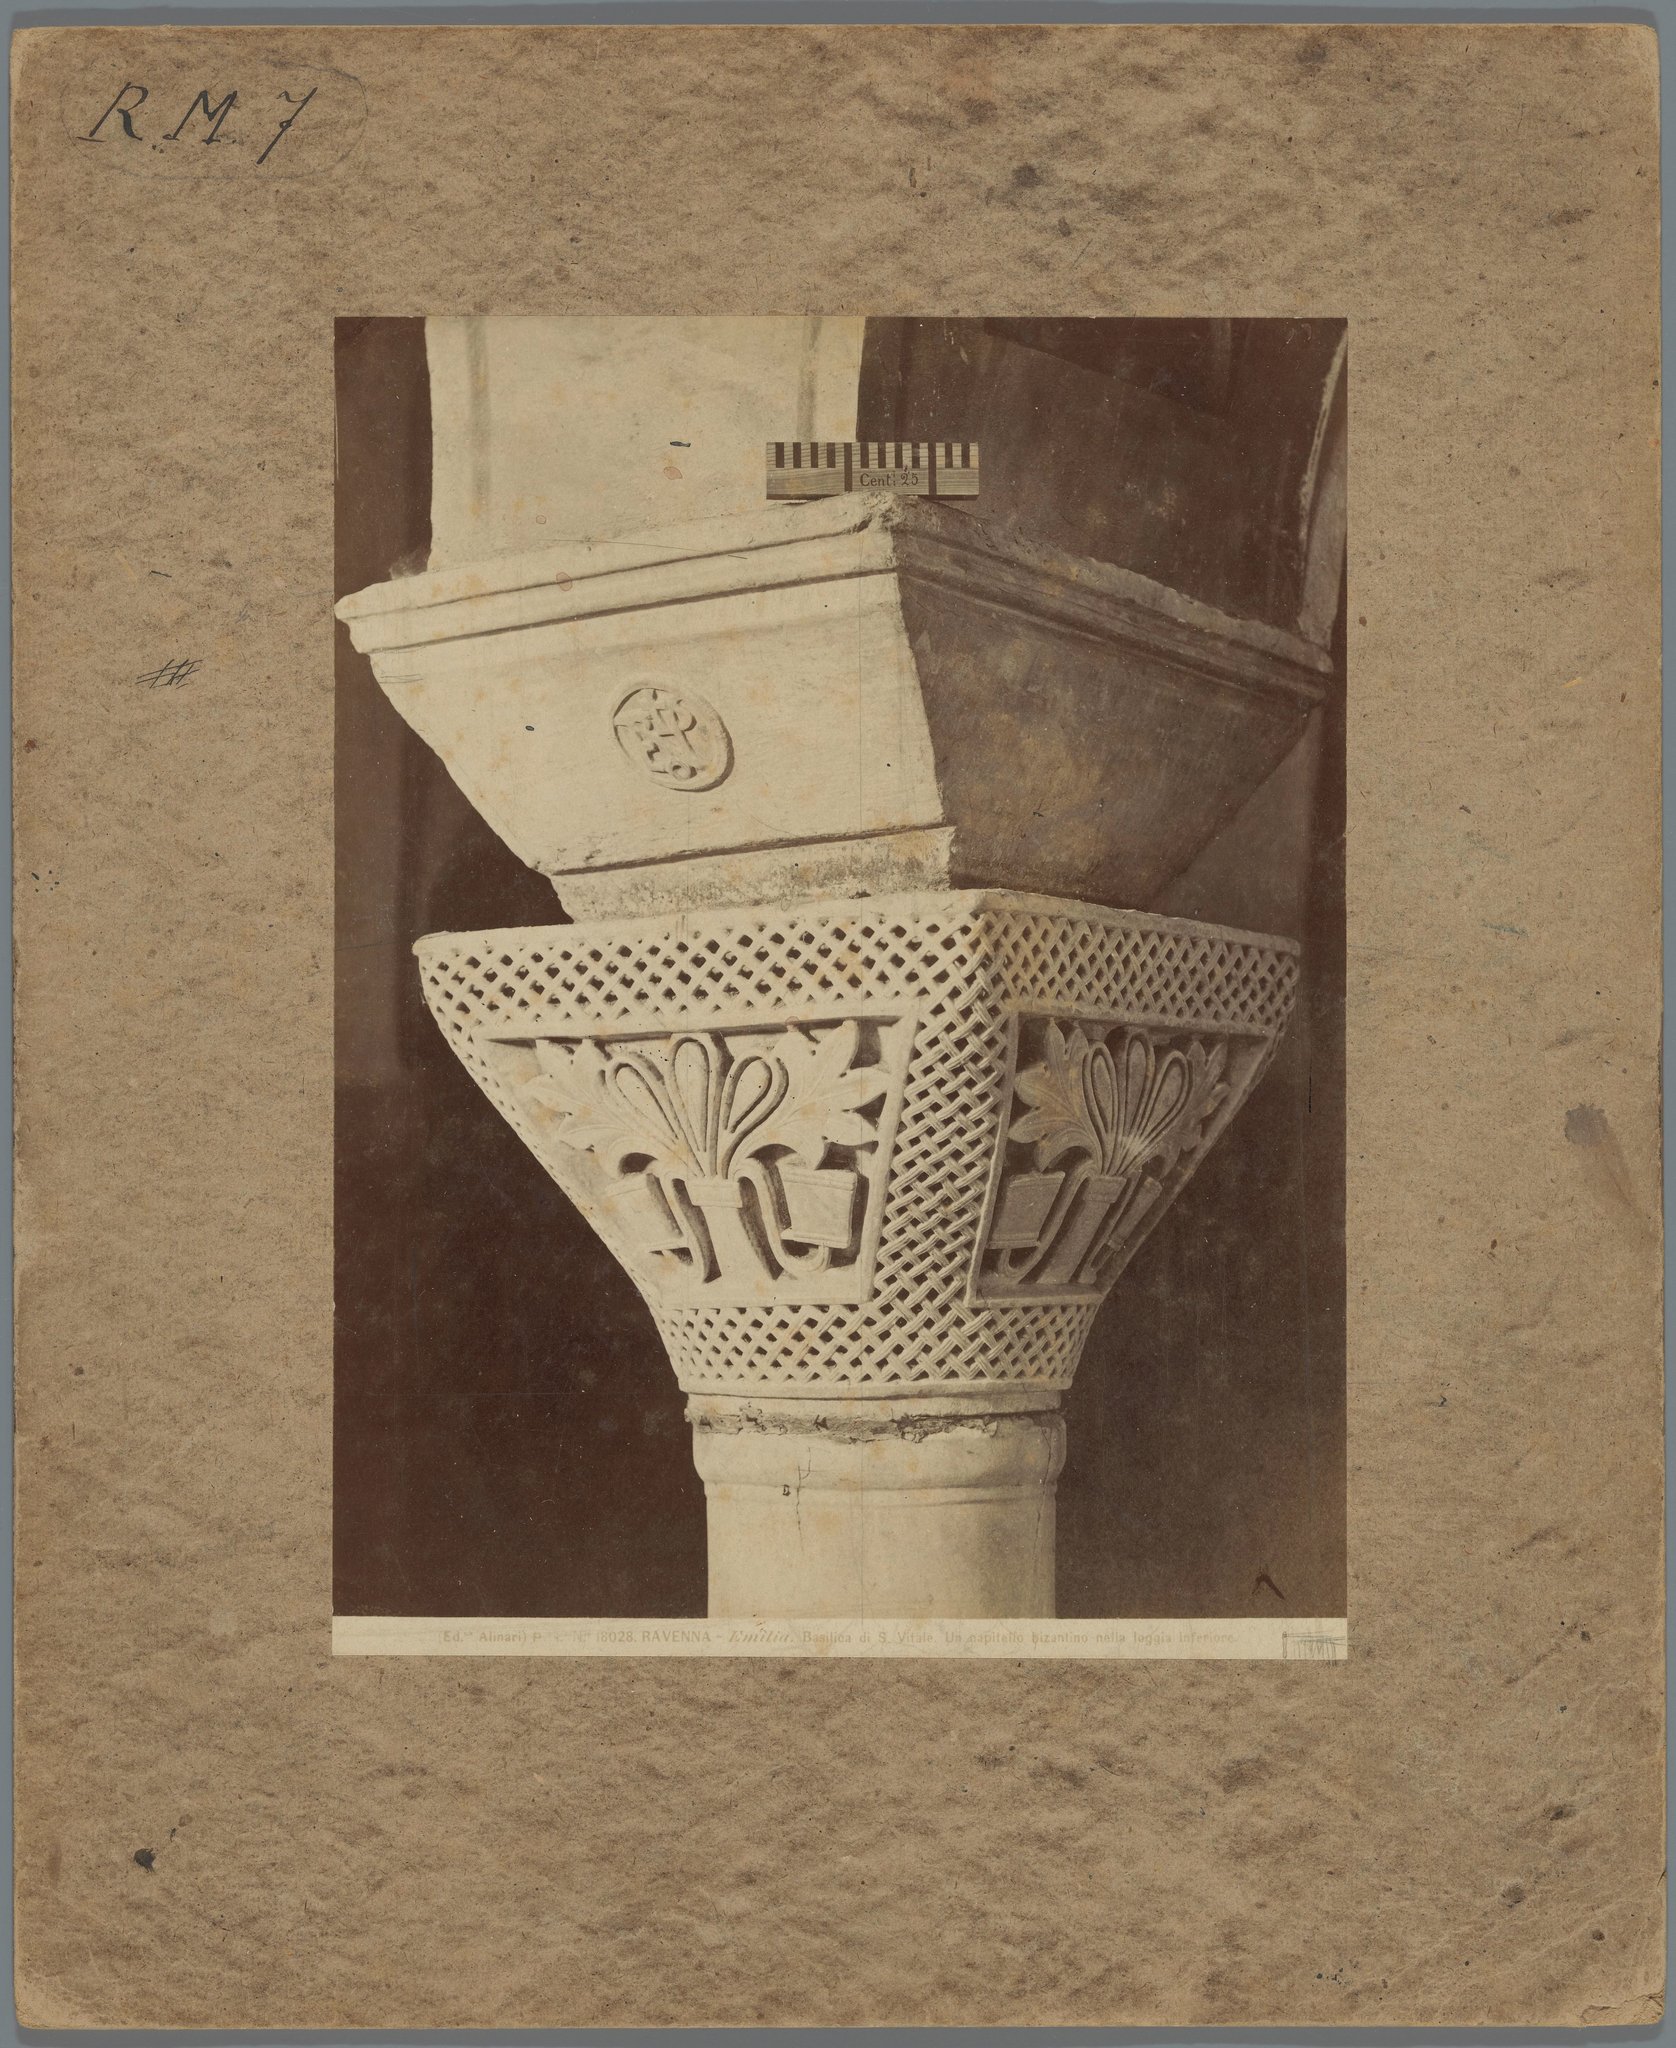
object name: photograph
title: Kapiteel van een zuil in de de basiliek van San Vitale te Ravenna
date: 1875-1900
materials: cardboard, photographic support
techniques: albumen print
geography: basilica di san vitale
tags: capital (~ column, pillar)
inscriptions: inscription: ‘R.M. 7’, number: ‘P[...]N.o 18028.’, collector's mark: Lugt 3937